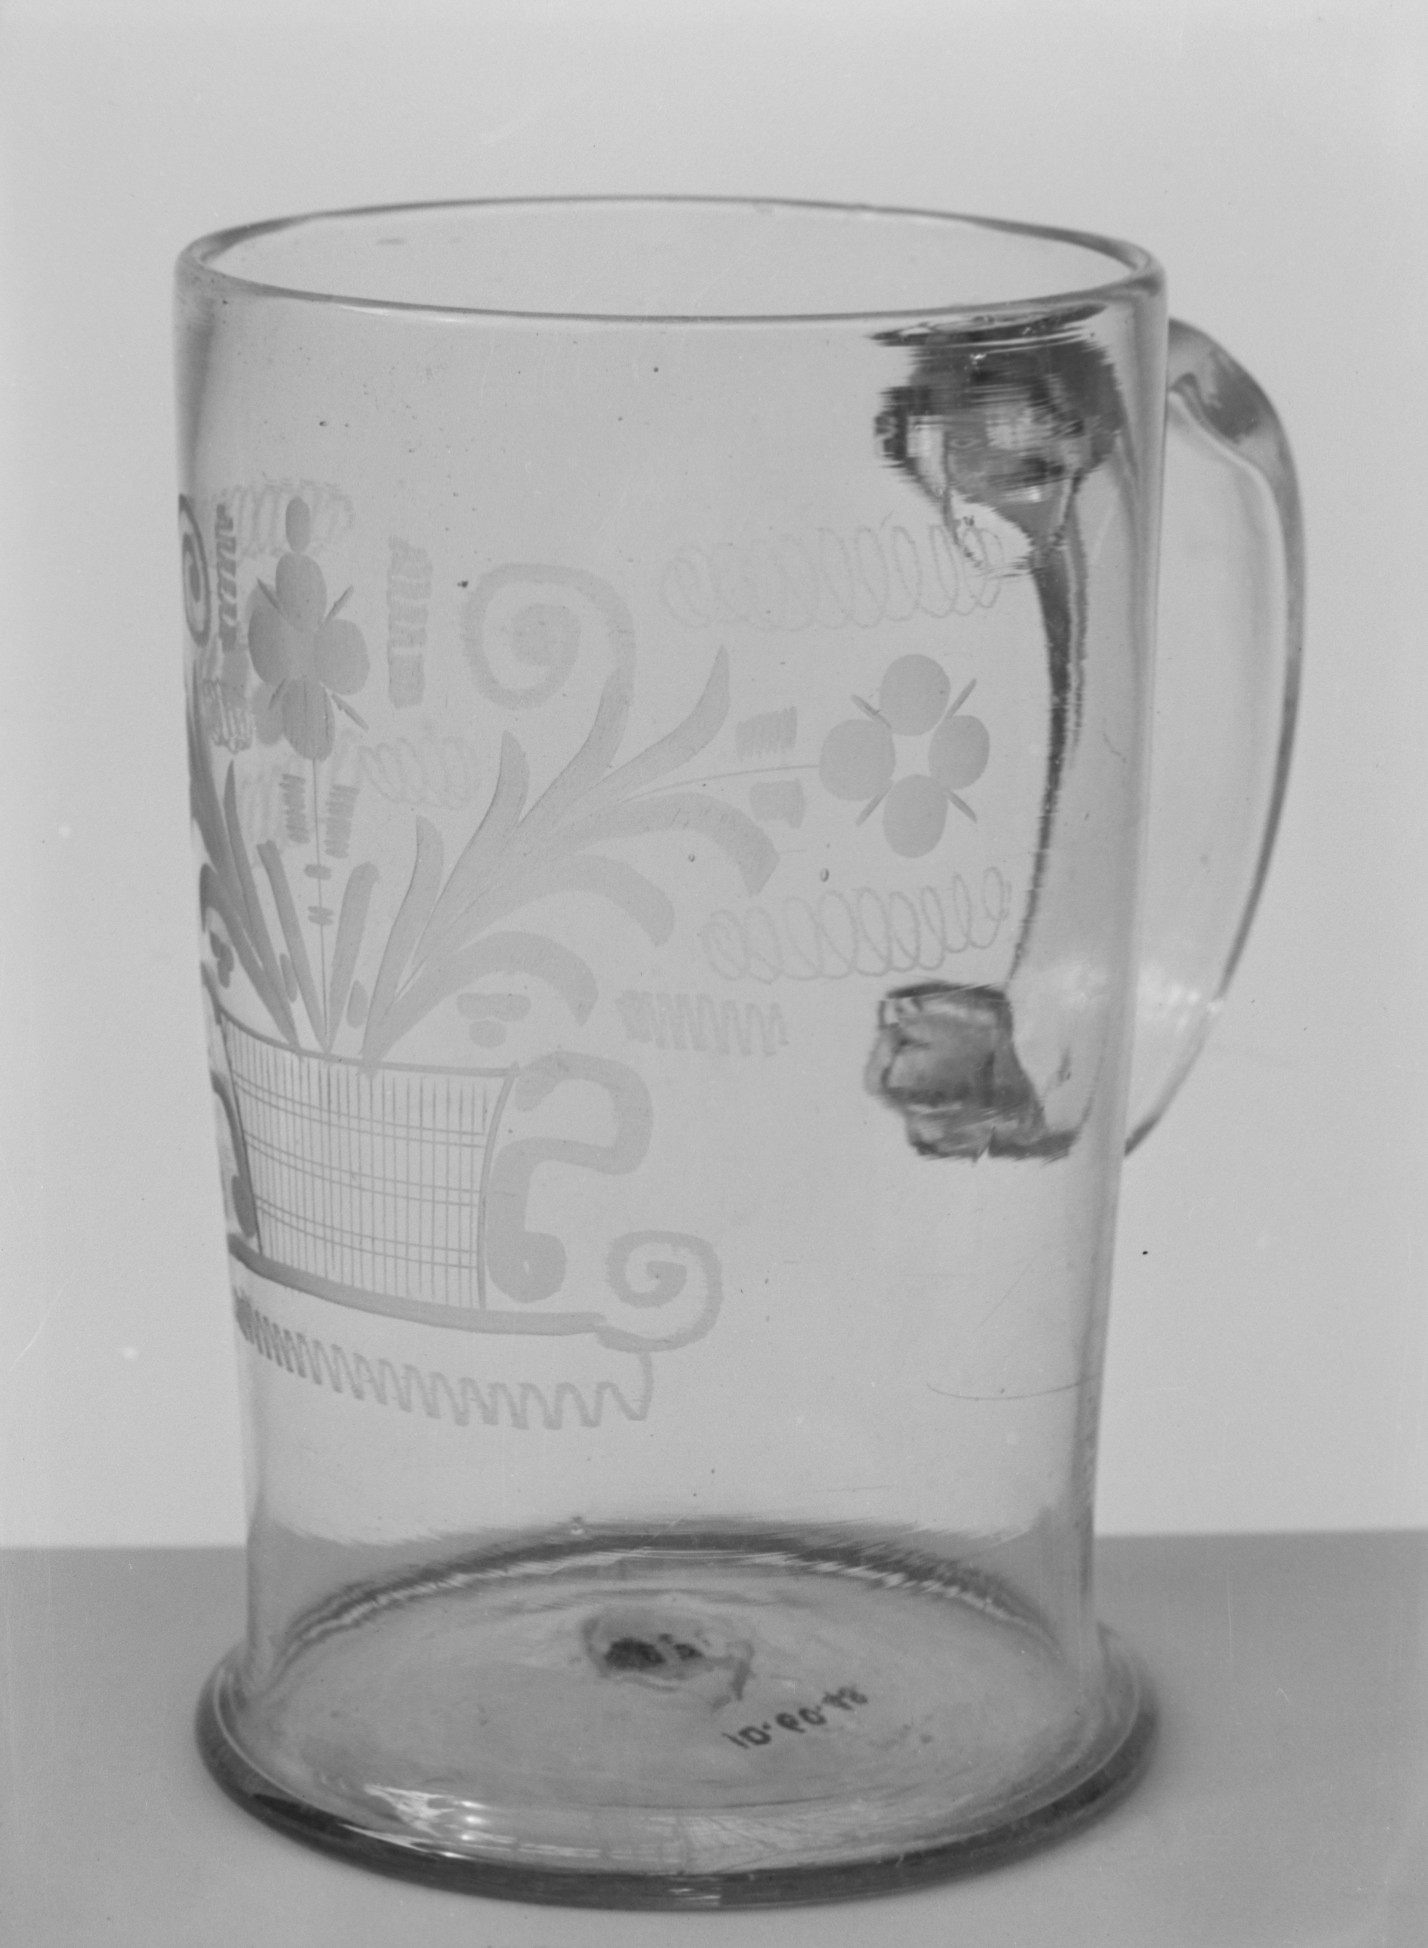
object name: mug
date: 1701-1800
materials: glass